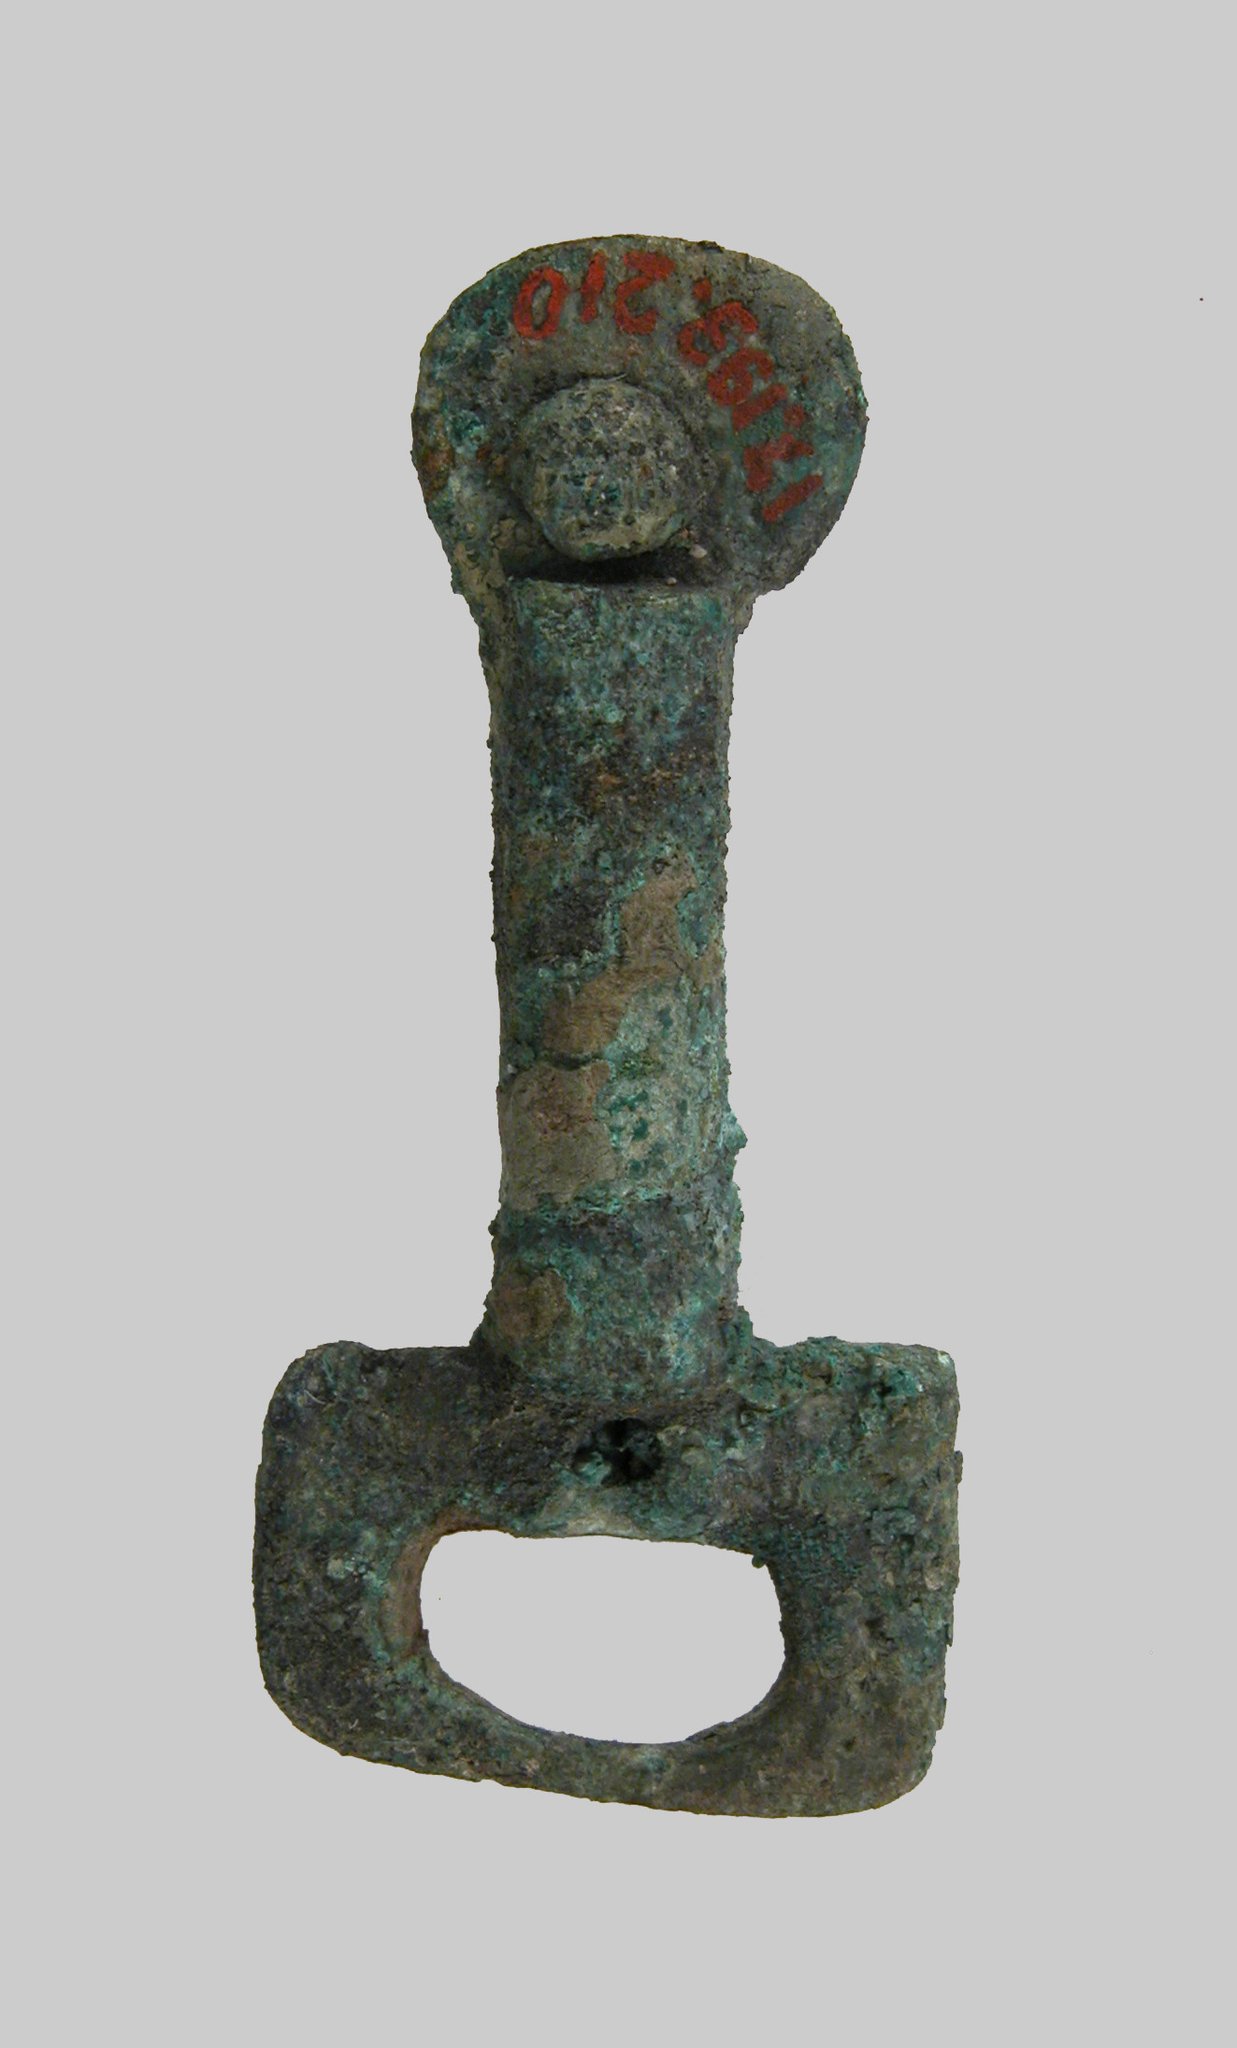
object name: plaque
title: Rectangular Plaque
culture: frankish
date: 500-700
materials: copper alloy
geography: germany